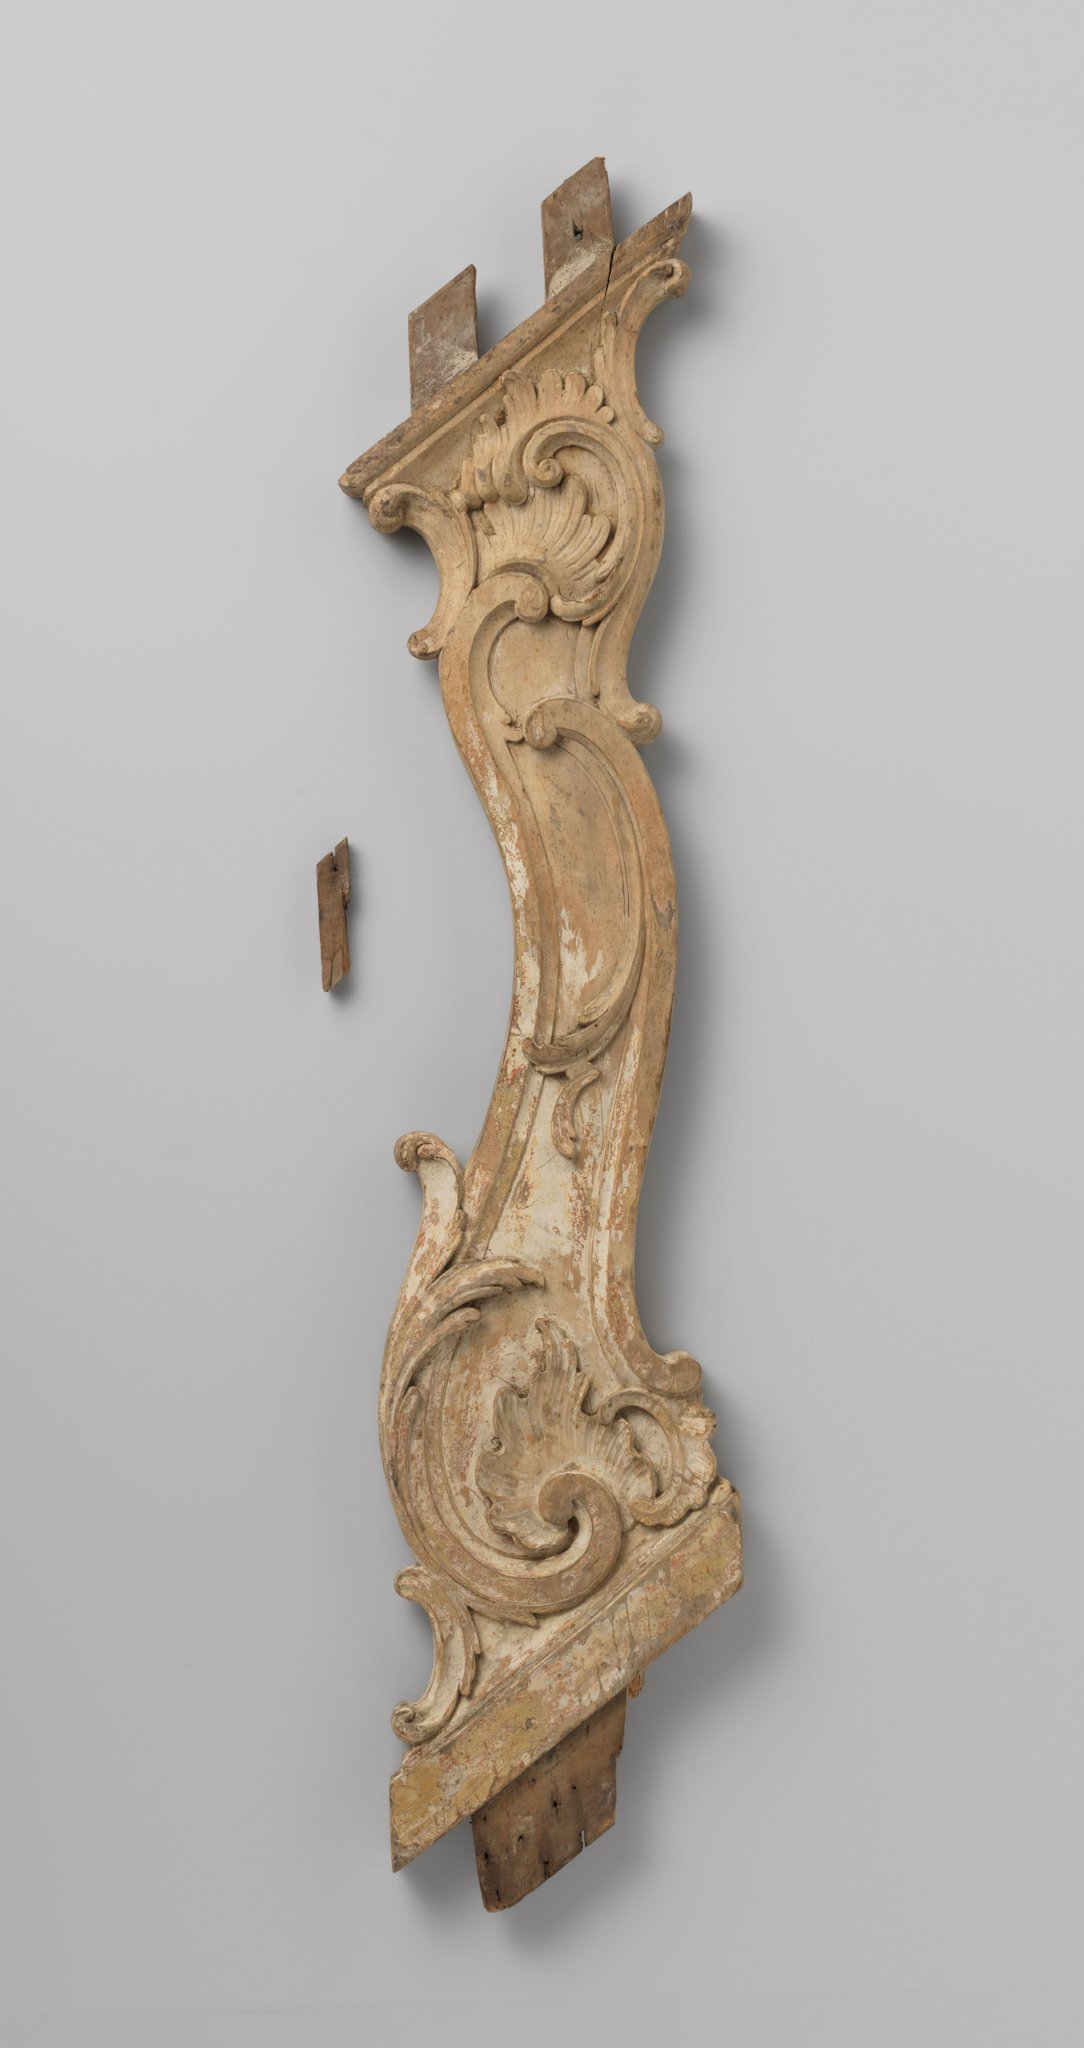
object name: trapbalustrade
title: Baluster met gestoken C- en S-voluten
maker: Anonymous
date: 1740-1760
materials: wood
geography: northern netherlands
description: S-vormige baluster met gestoken C- en S-voluten met rocaille-schelpen.